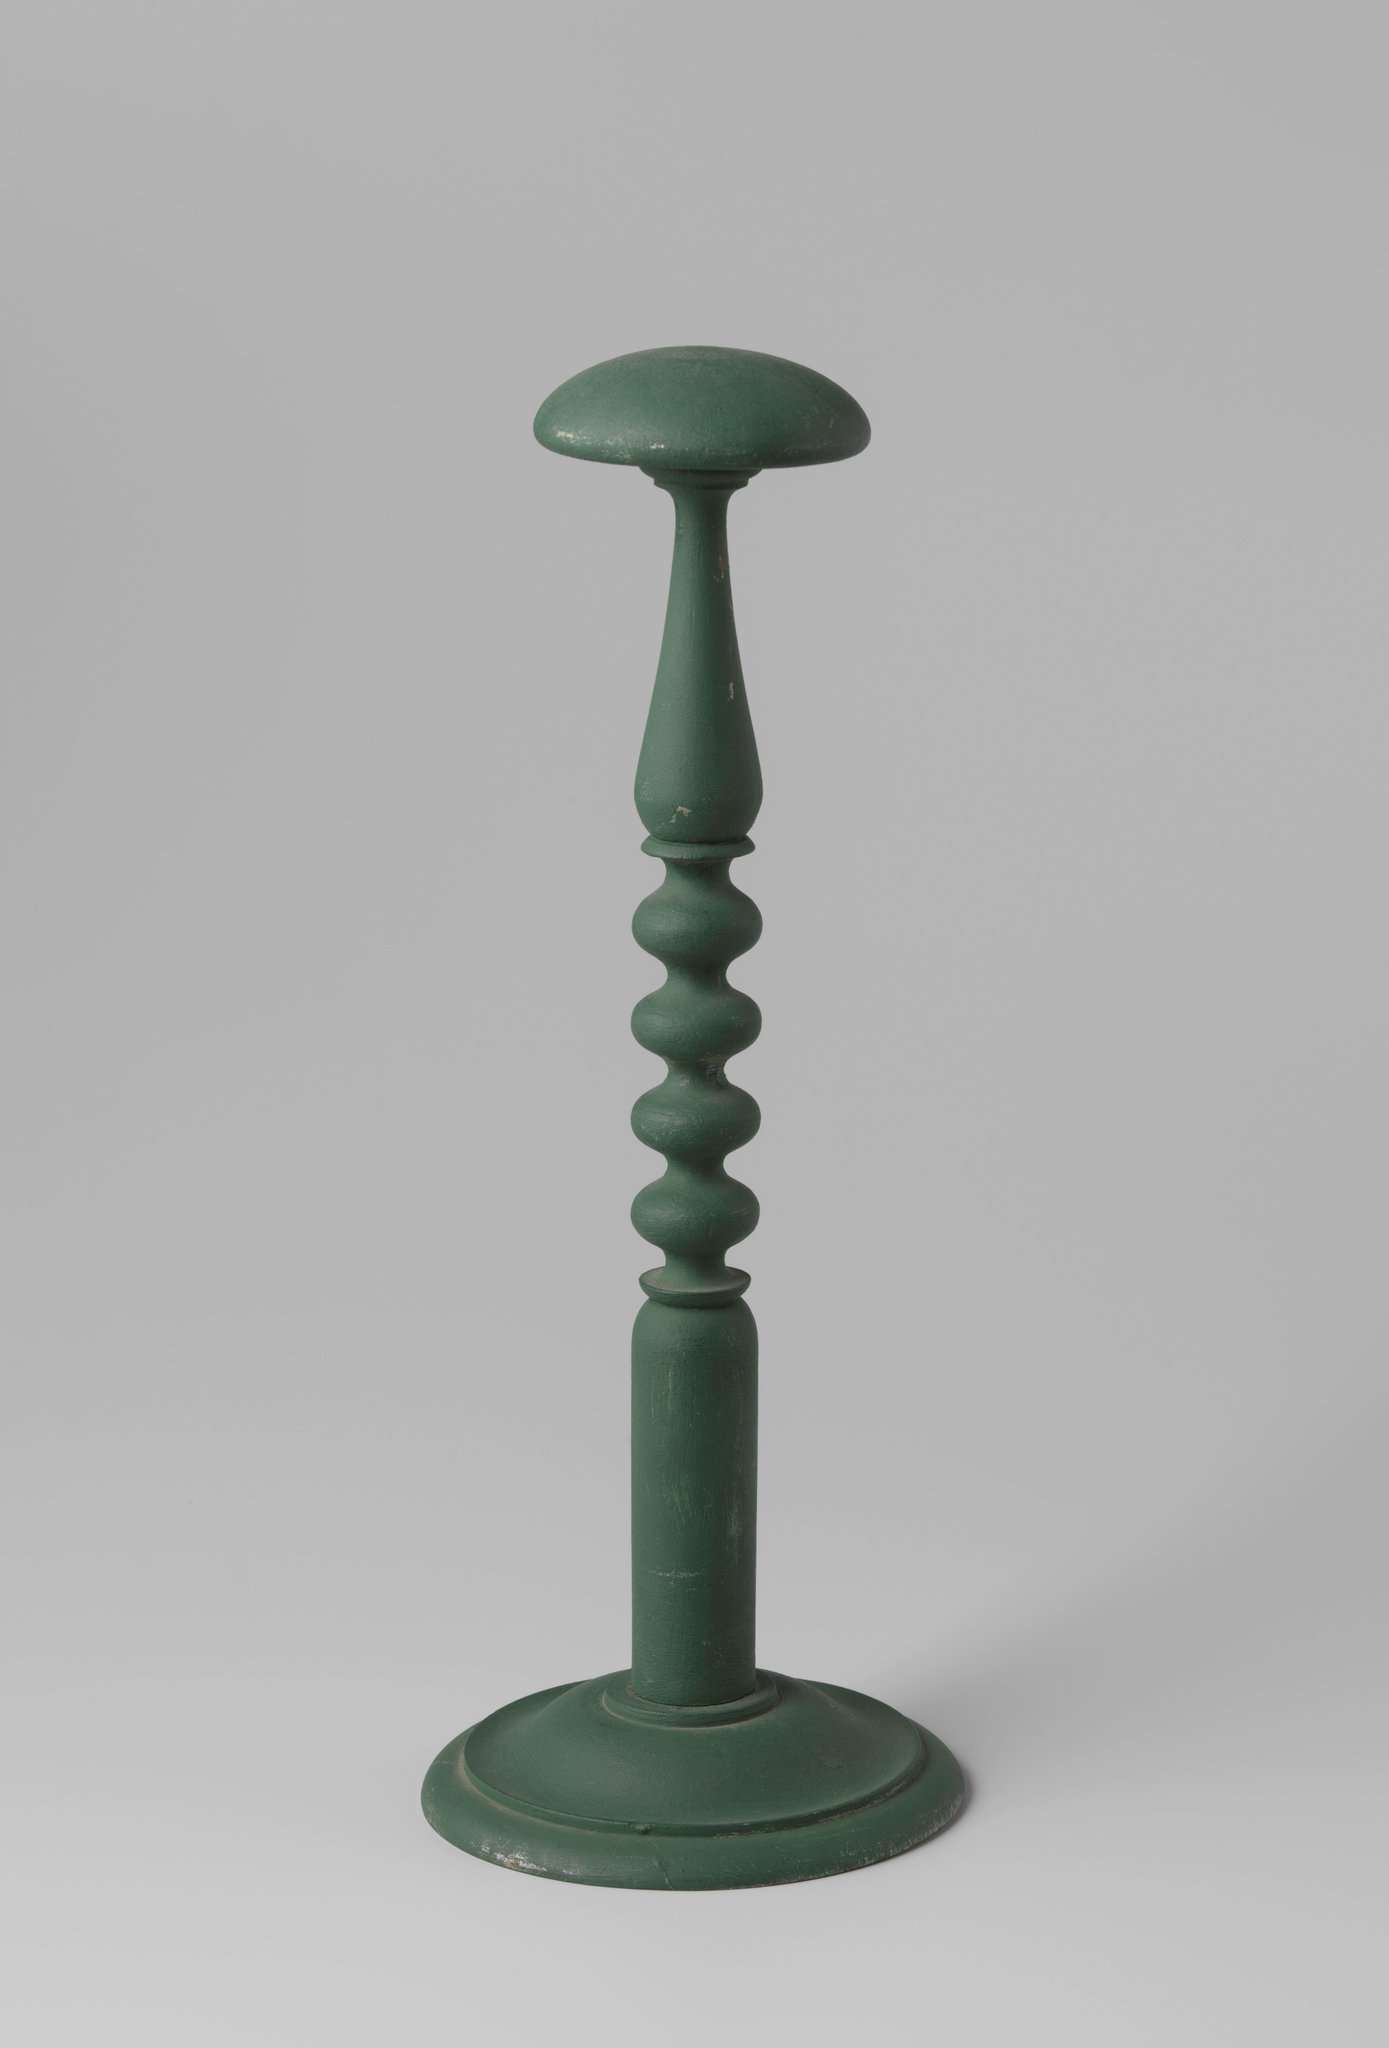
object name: hat stand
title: Hoedenstandaard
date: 1915-1935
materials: wood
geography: netherlands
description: Hoedenstandaard van dof groen geschilderd hout. Middelhoog, opgebouwd uit een recht schachtdeel, een ris van vier knopen en een baluster, voet met profiel.